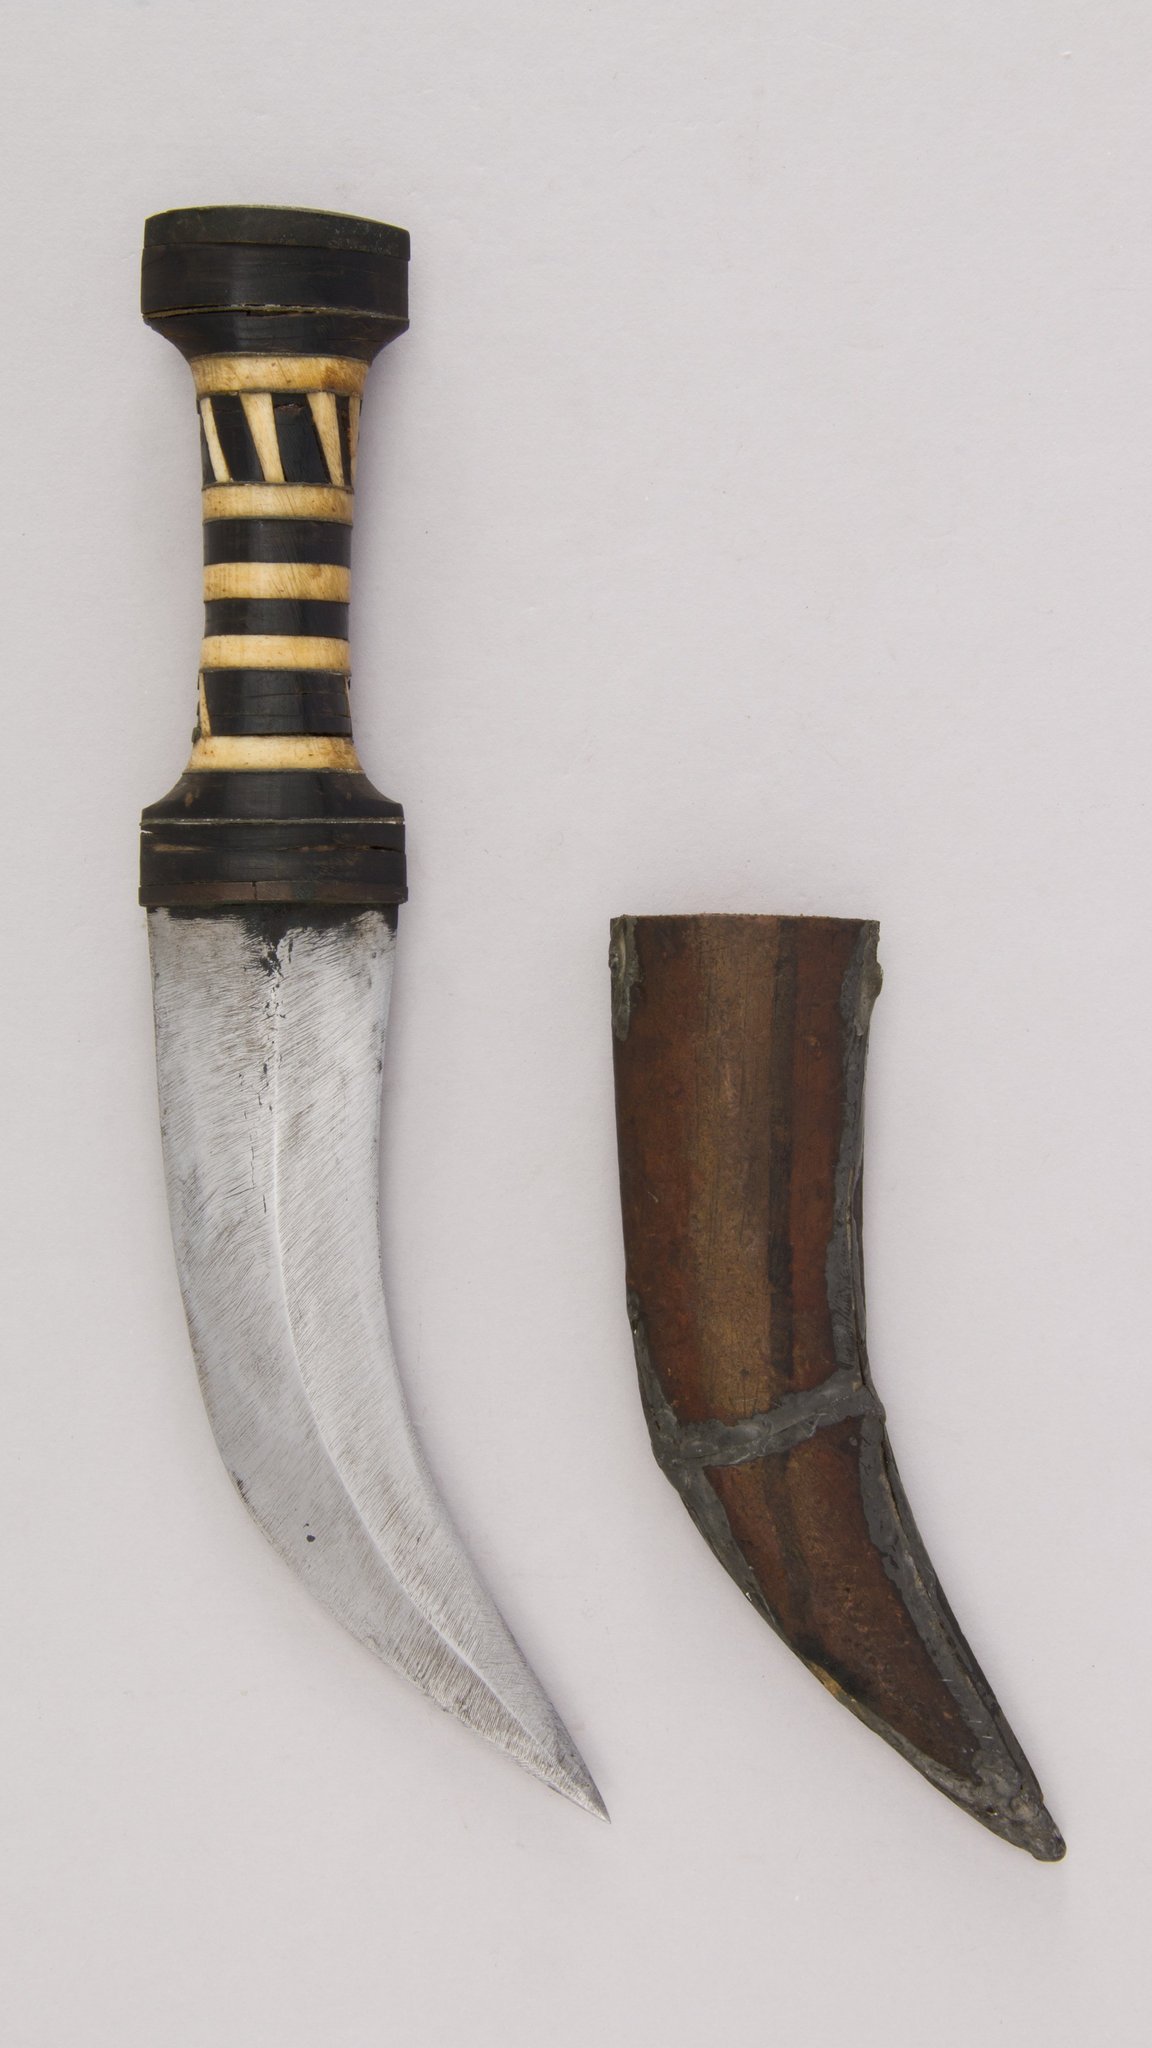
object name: dagger with sheath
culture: syrian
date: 1701-1900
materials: bone, brass, horn, steel, wood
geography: syria